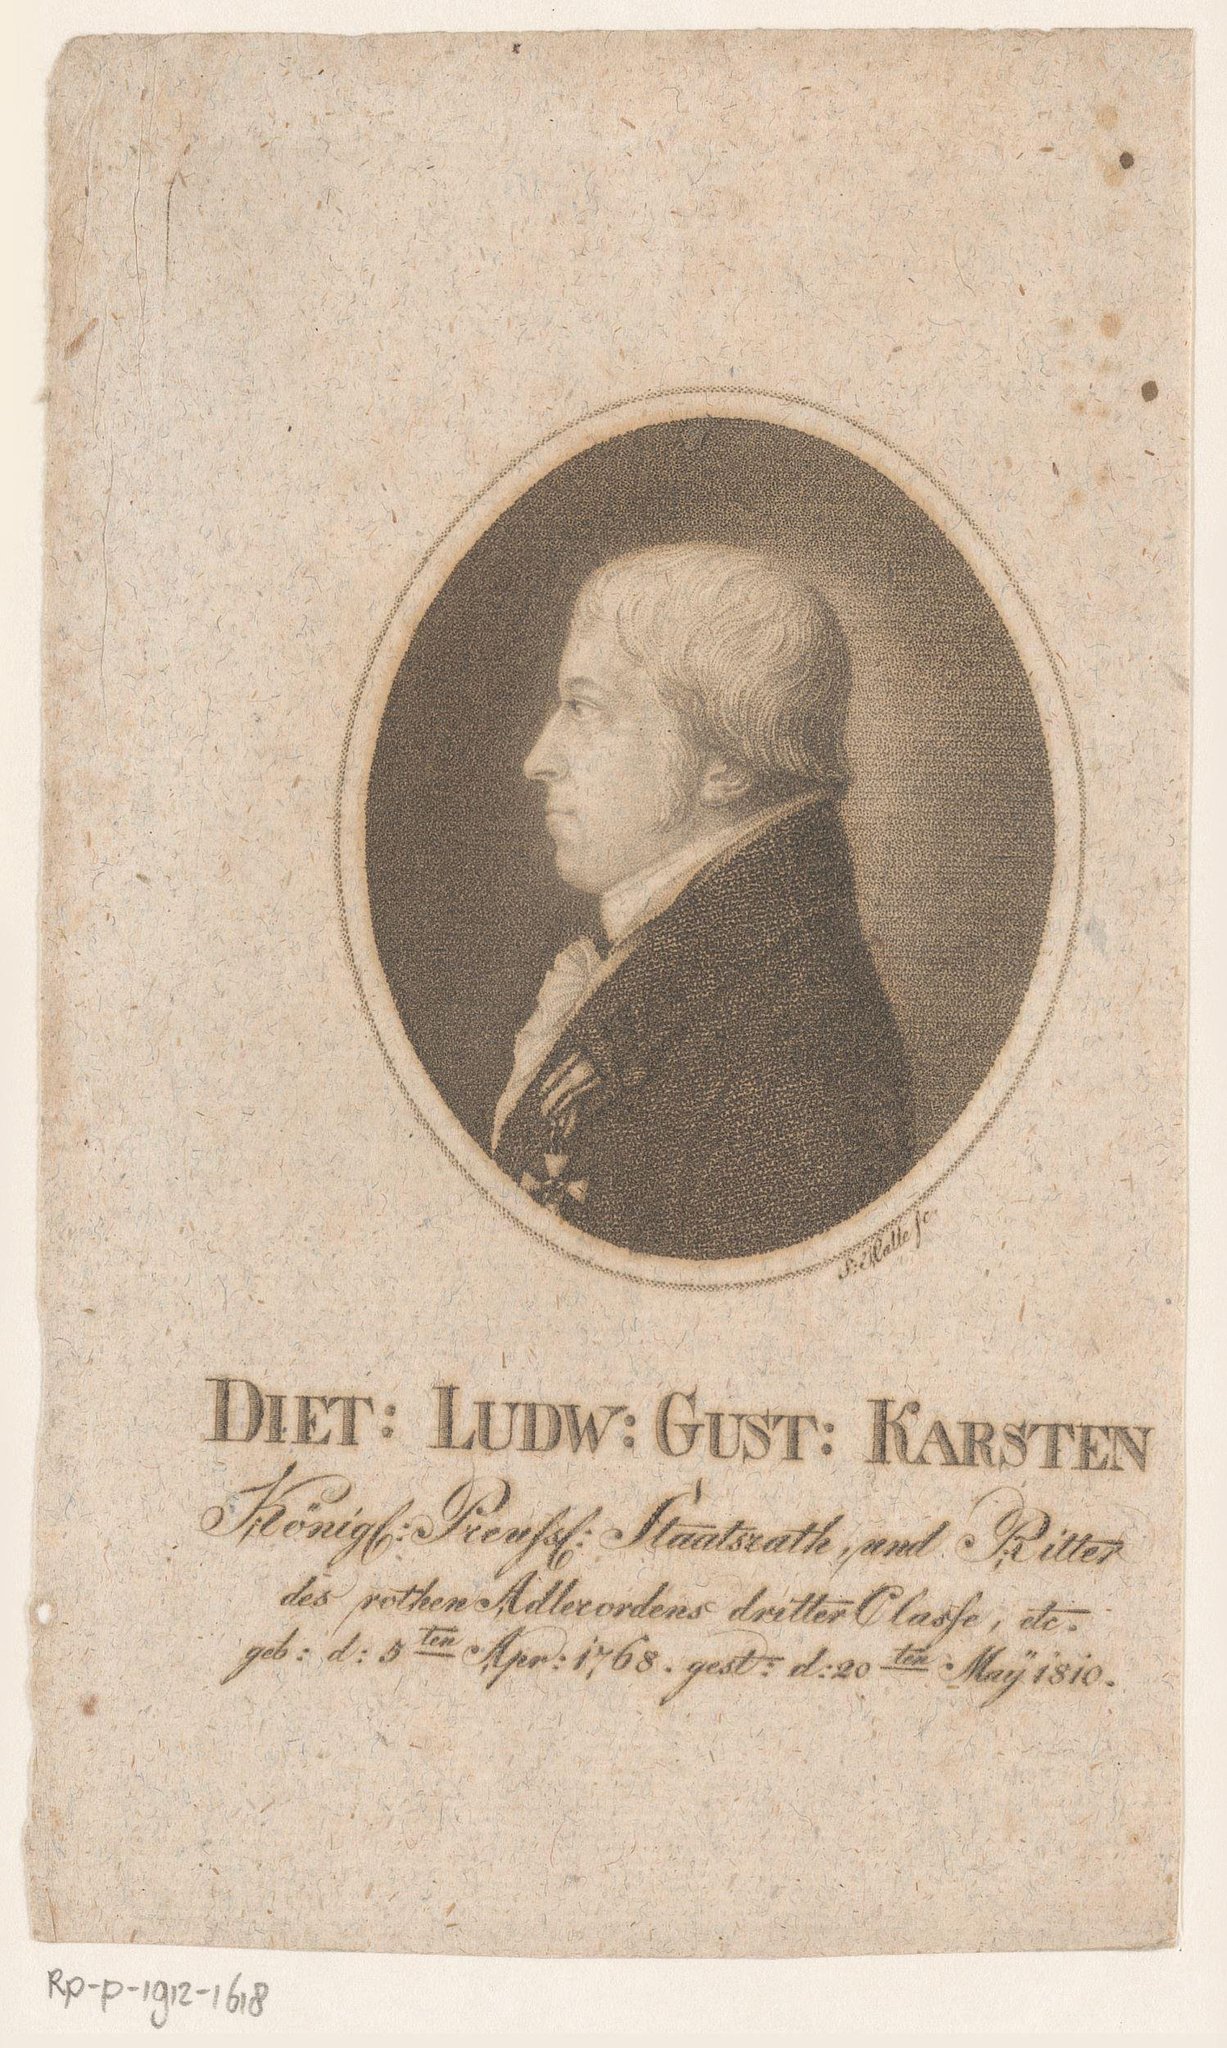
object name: print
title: Portret van Dietrich Ludwig Gustav Karsten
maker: johann samuel ludwig halle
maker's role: print maker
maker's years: 1763-1829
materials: paper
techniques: stippling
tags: berlin, historical persons, medals and other marks of military honour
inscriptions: collector's mark: Lugt 2228